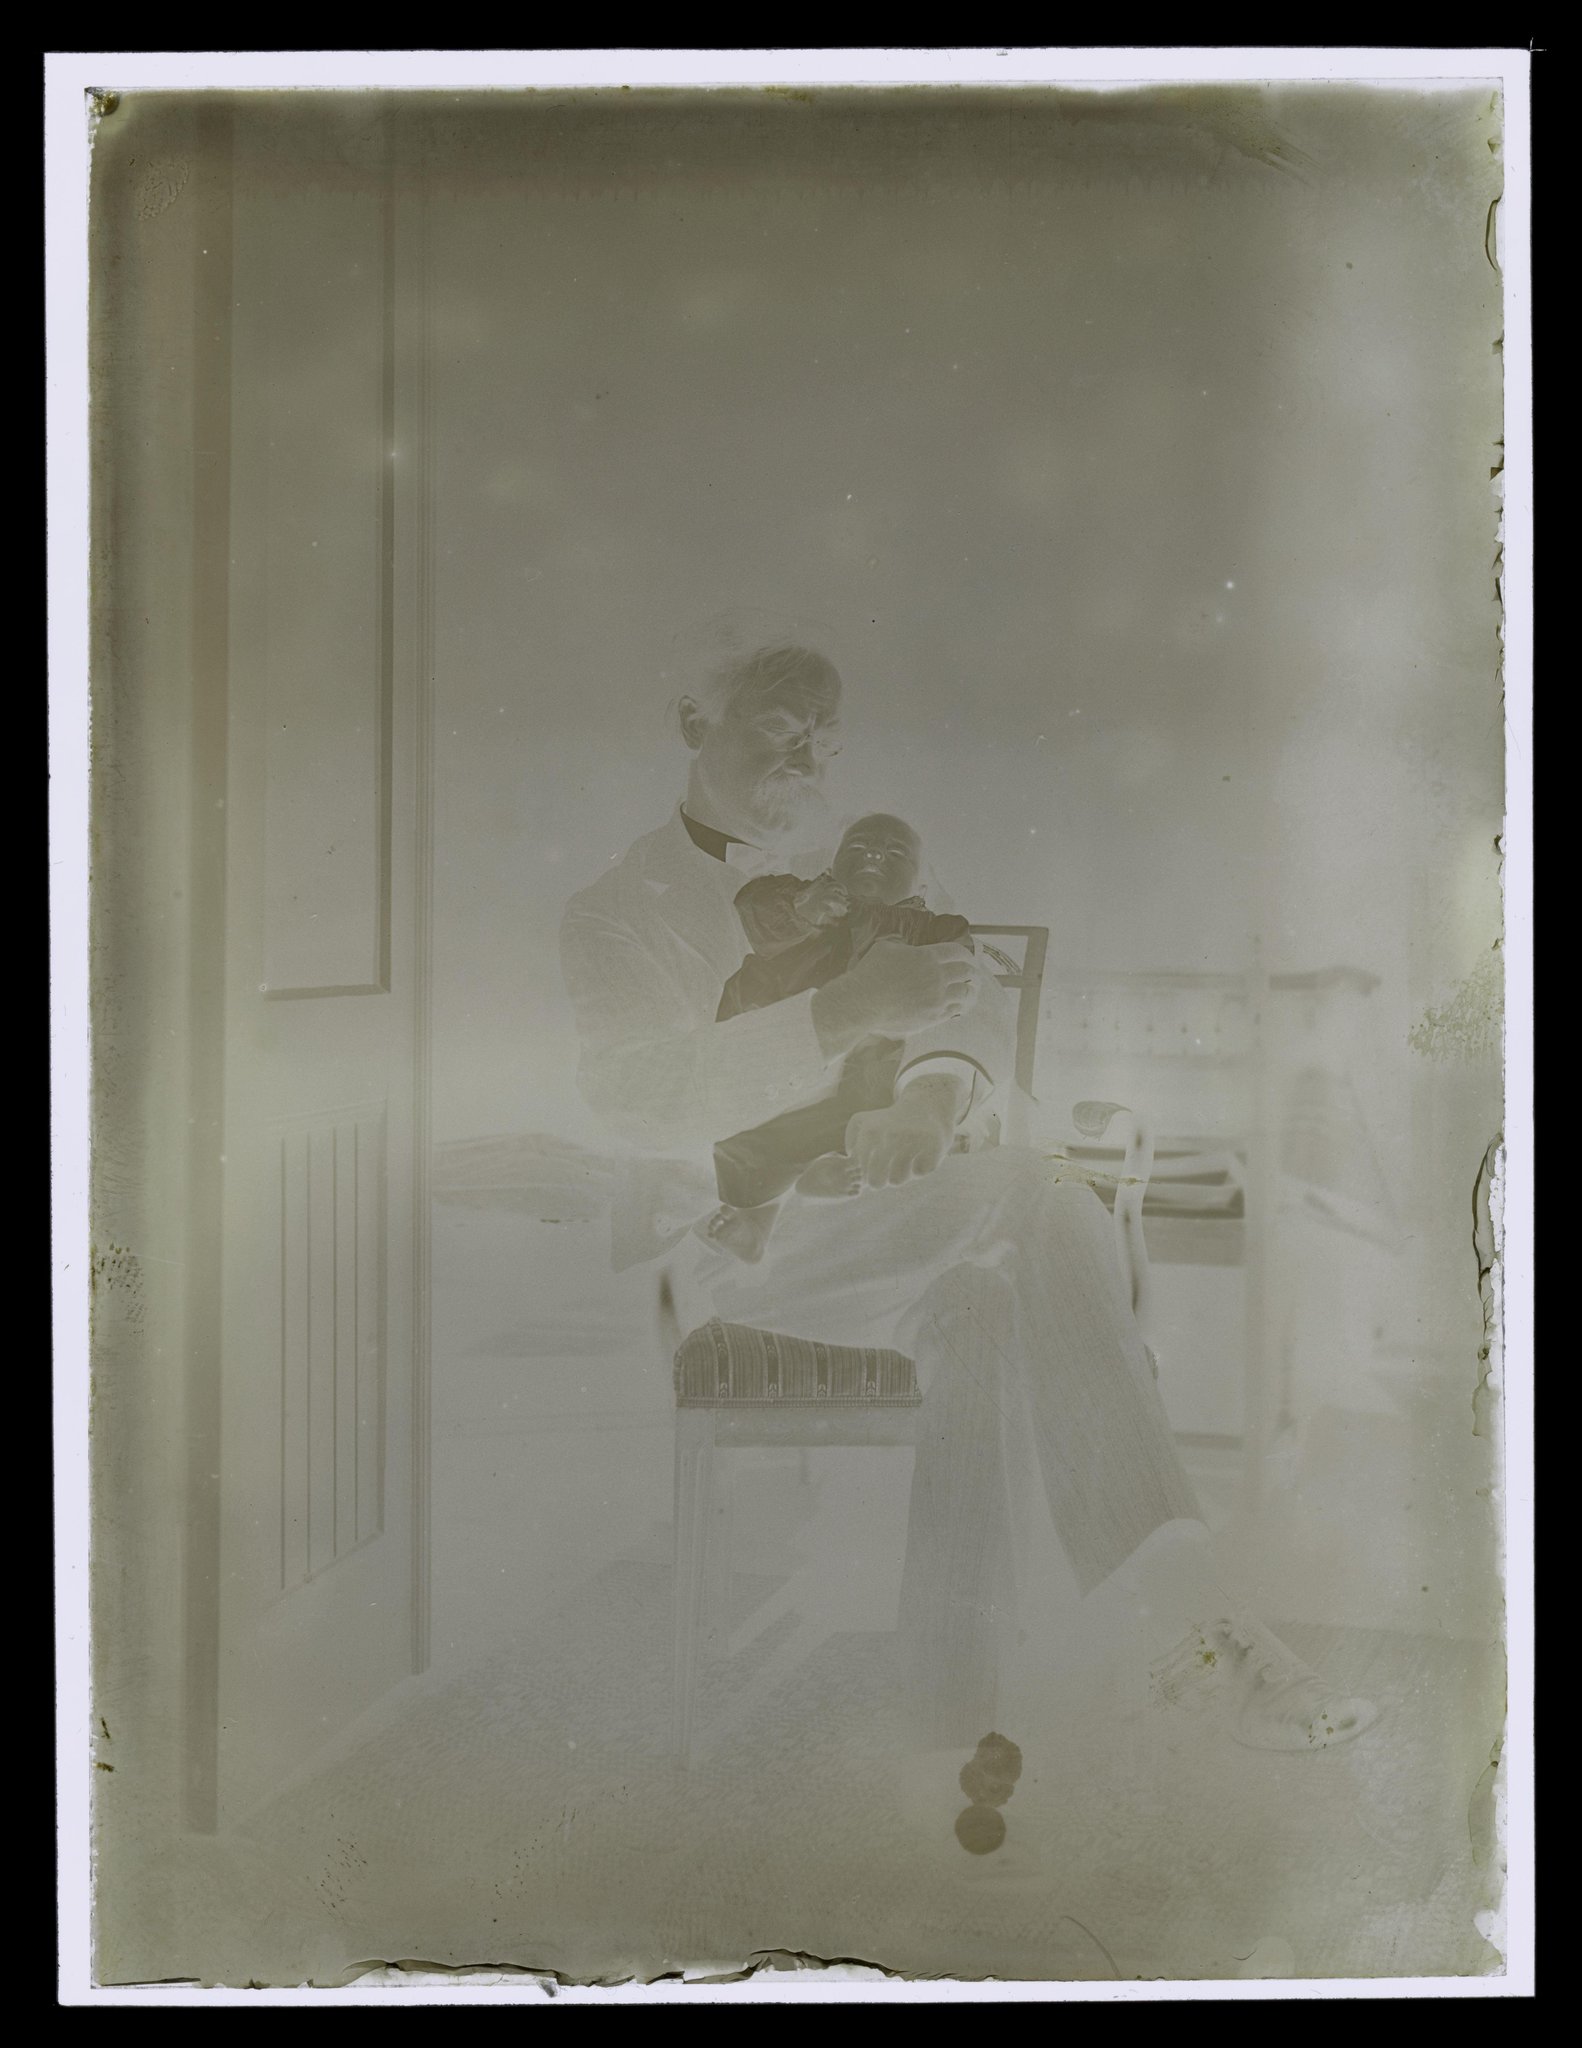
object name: glasnegatief, glasplaatnegatief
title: Alphons Diepenbrock met baby, mogelijk dochter Thea Diepenbrock, in zijn armen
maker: wouterus gijsbertus hondius van den broek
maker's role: amateurfotograaf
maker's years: 1867-1913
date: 1907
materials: glass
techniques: gelatin glass negative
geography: netherlands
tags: amsterdam, alphons diepenbrock, sitting figure, adult man, infant, baby